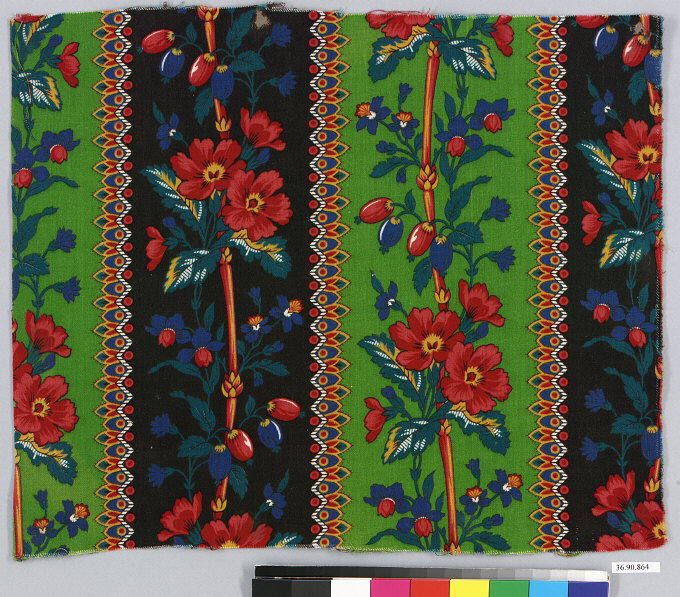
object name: piece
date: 1801-1900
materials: cotton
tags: flowers,leaves